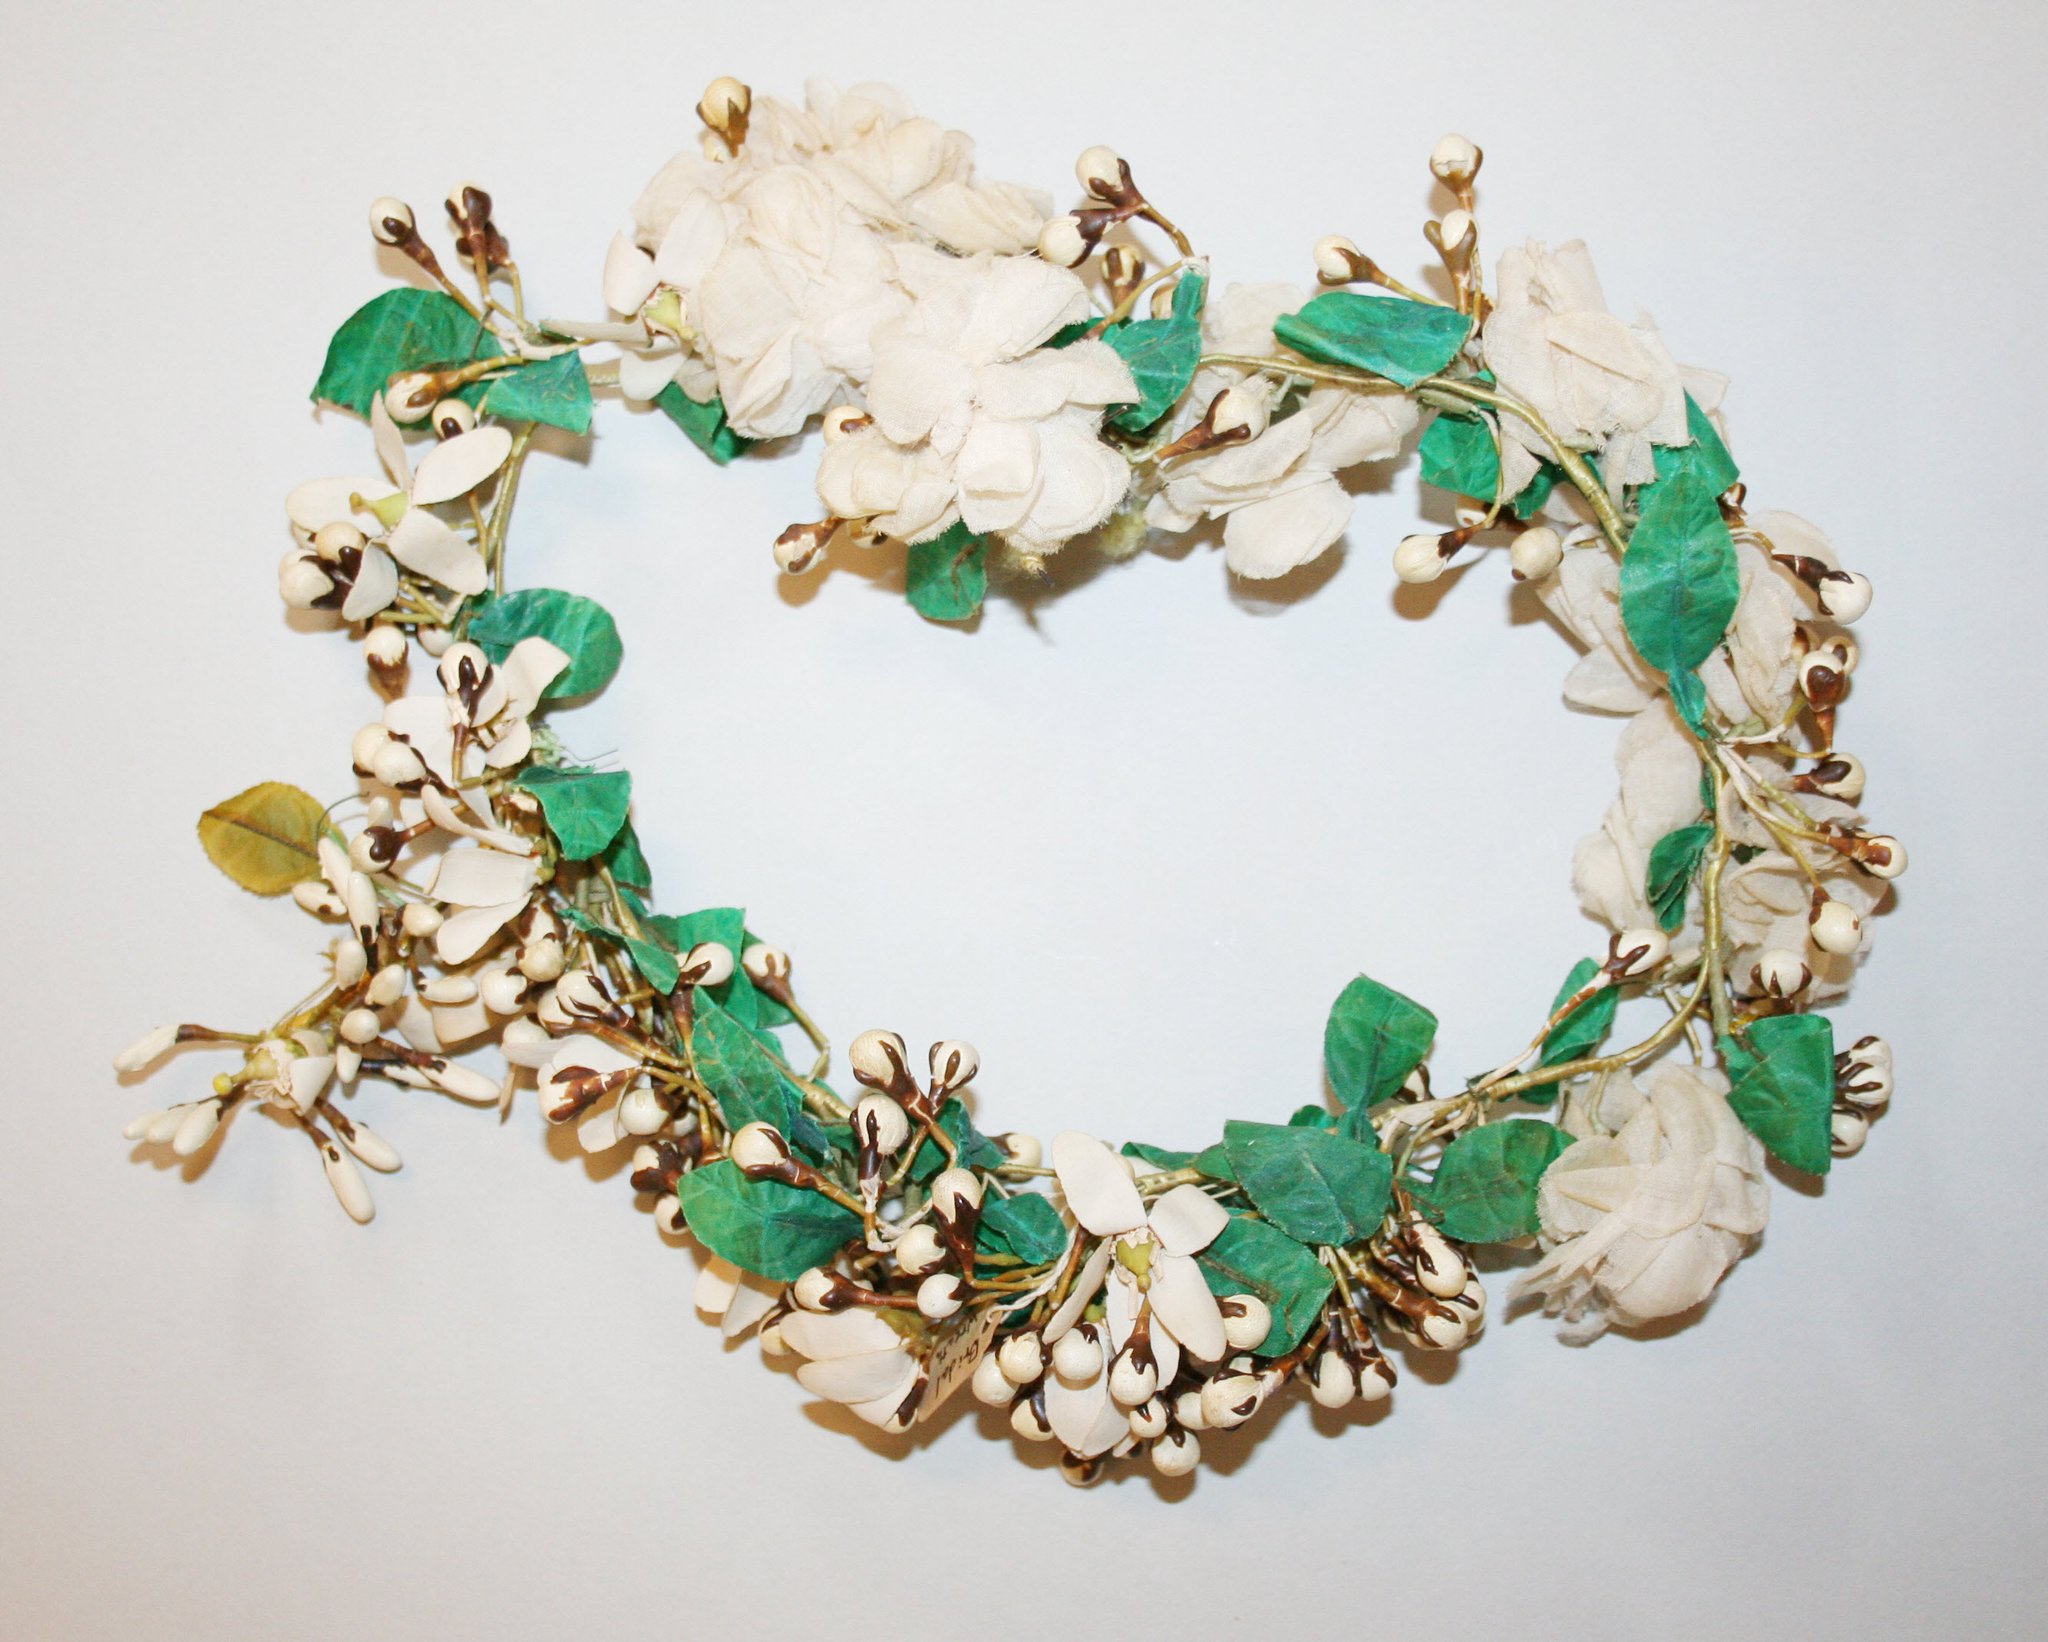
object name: wedding headdress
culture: american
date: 1863